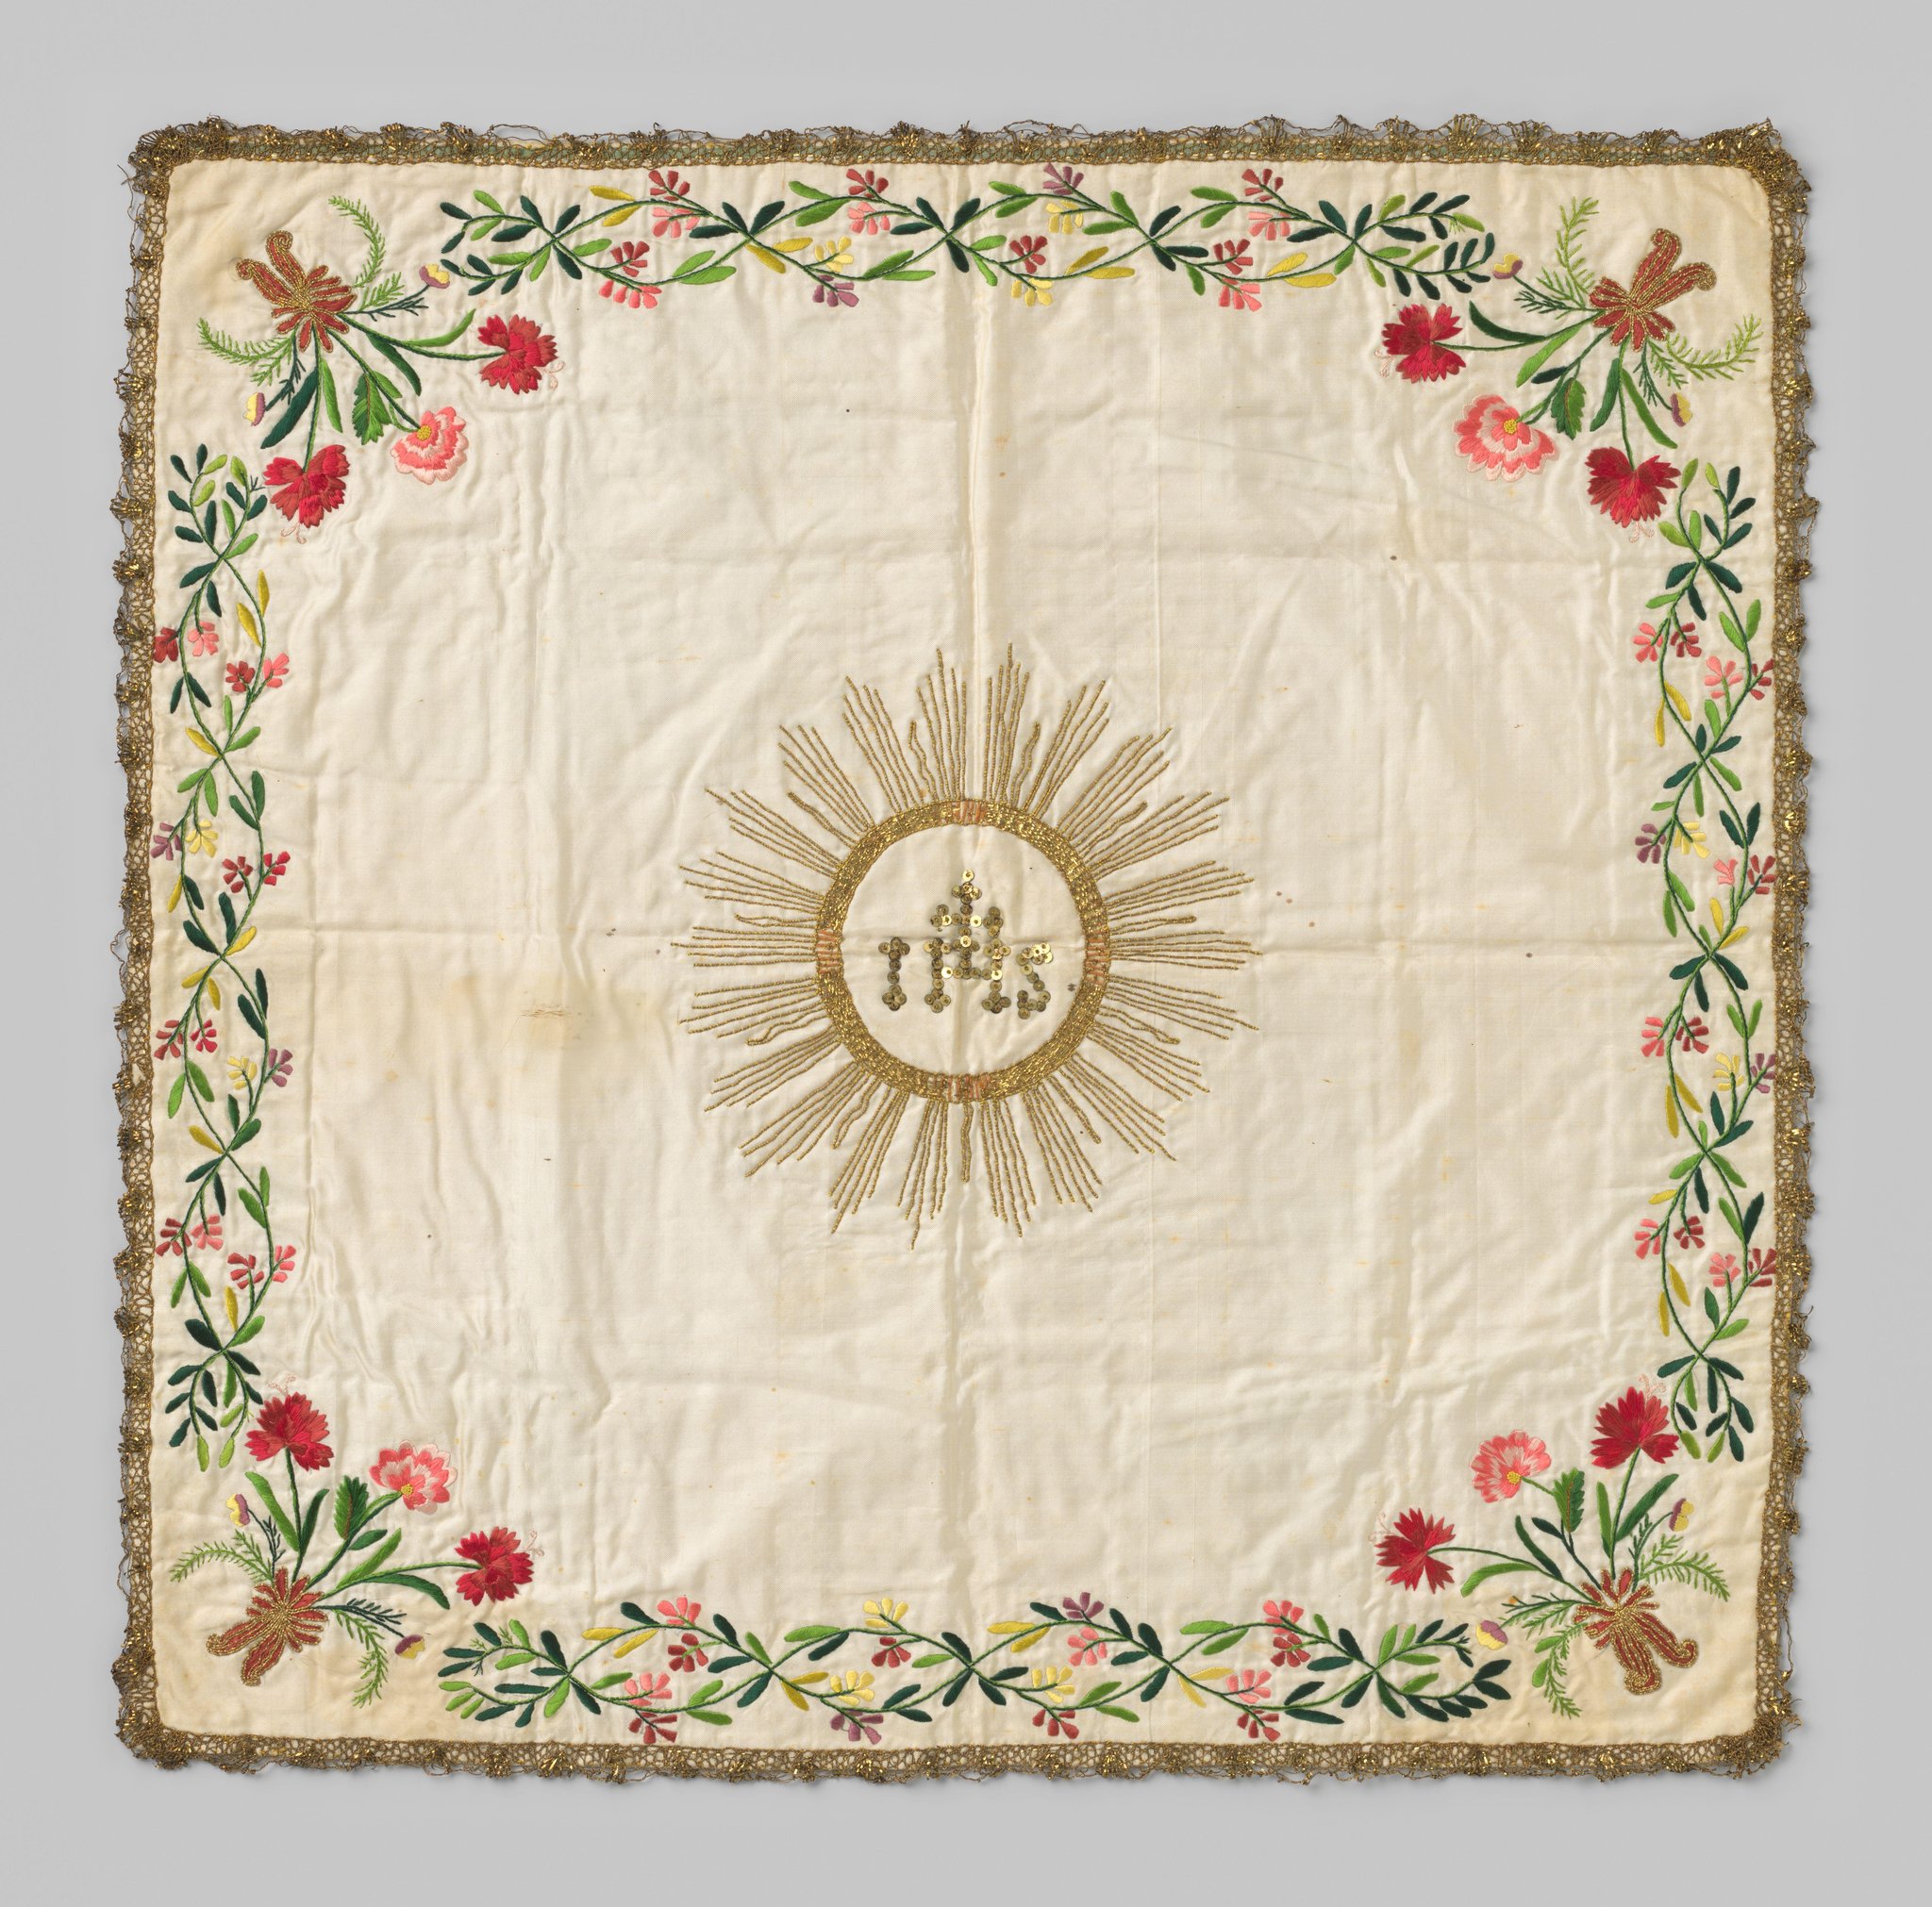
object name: chalice veil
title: Kelkvelum van zijde geborduurd met stralenkrans in gouddraad waarbinnen in goudkleurige paillettes IHS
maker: Anonymous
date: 1800-1899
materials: gold thread, linen, silk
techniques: embroidered, weave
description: Kelkvelum van cremekleurige zijde met borduurwerk. In het midden een stralenkrans van gouddraad waarbinnen, met goudkleurige paillettes, de letters IHS. Langs de randen veelkleurig zijden borduursel: elkaar oversnijdende bloemtakken met schuin in de hoeken een bloemboeket (ook gouddraad). Omboord met kloskant: goudkant. Voering van linnen.